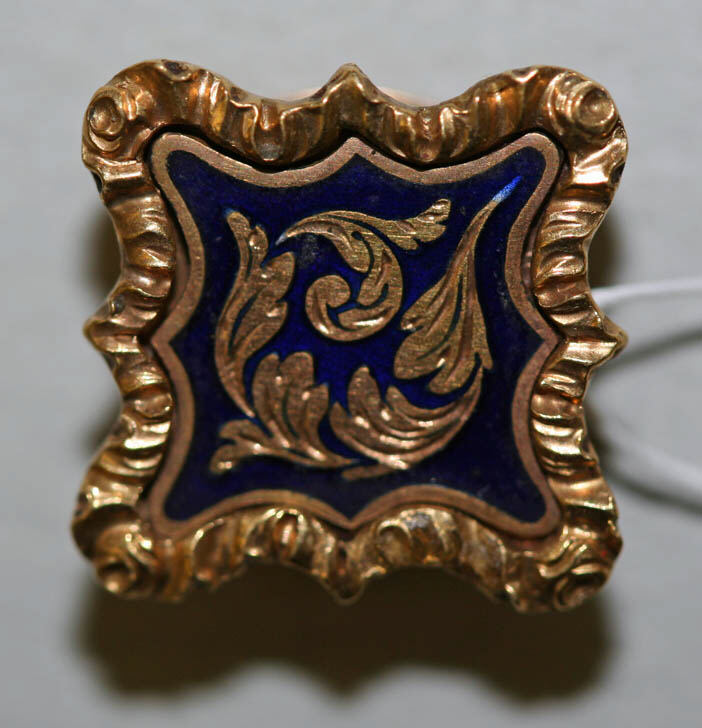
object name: stud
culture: french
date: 1701-1900